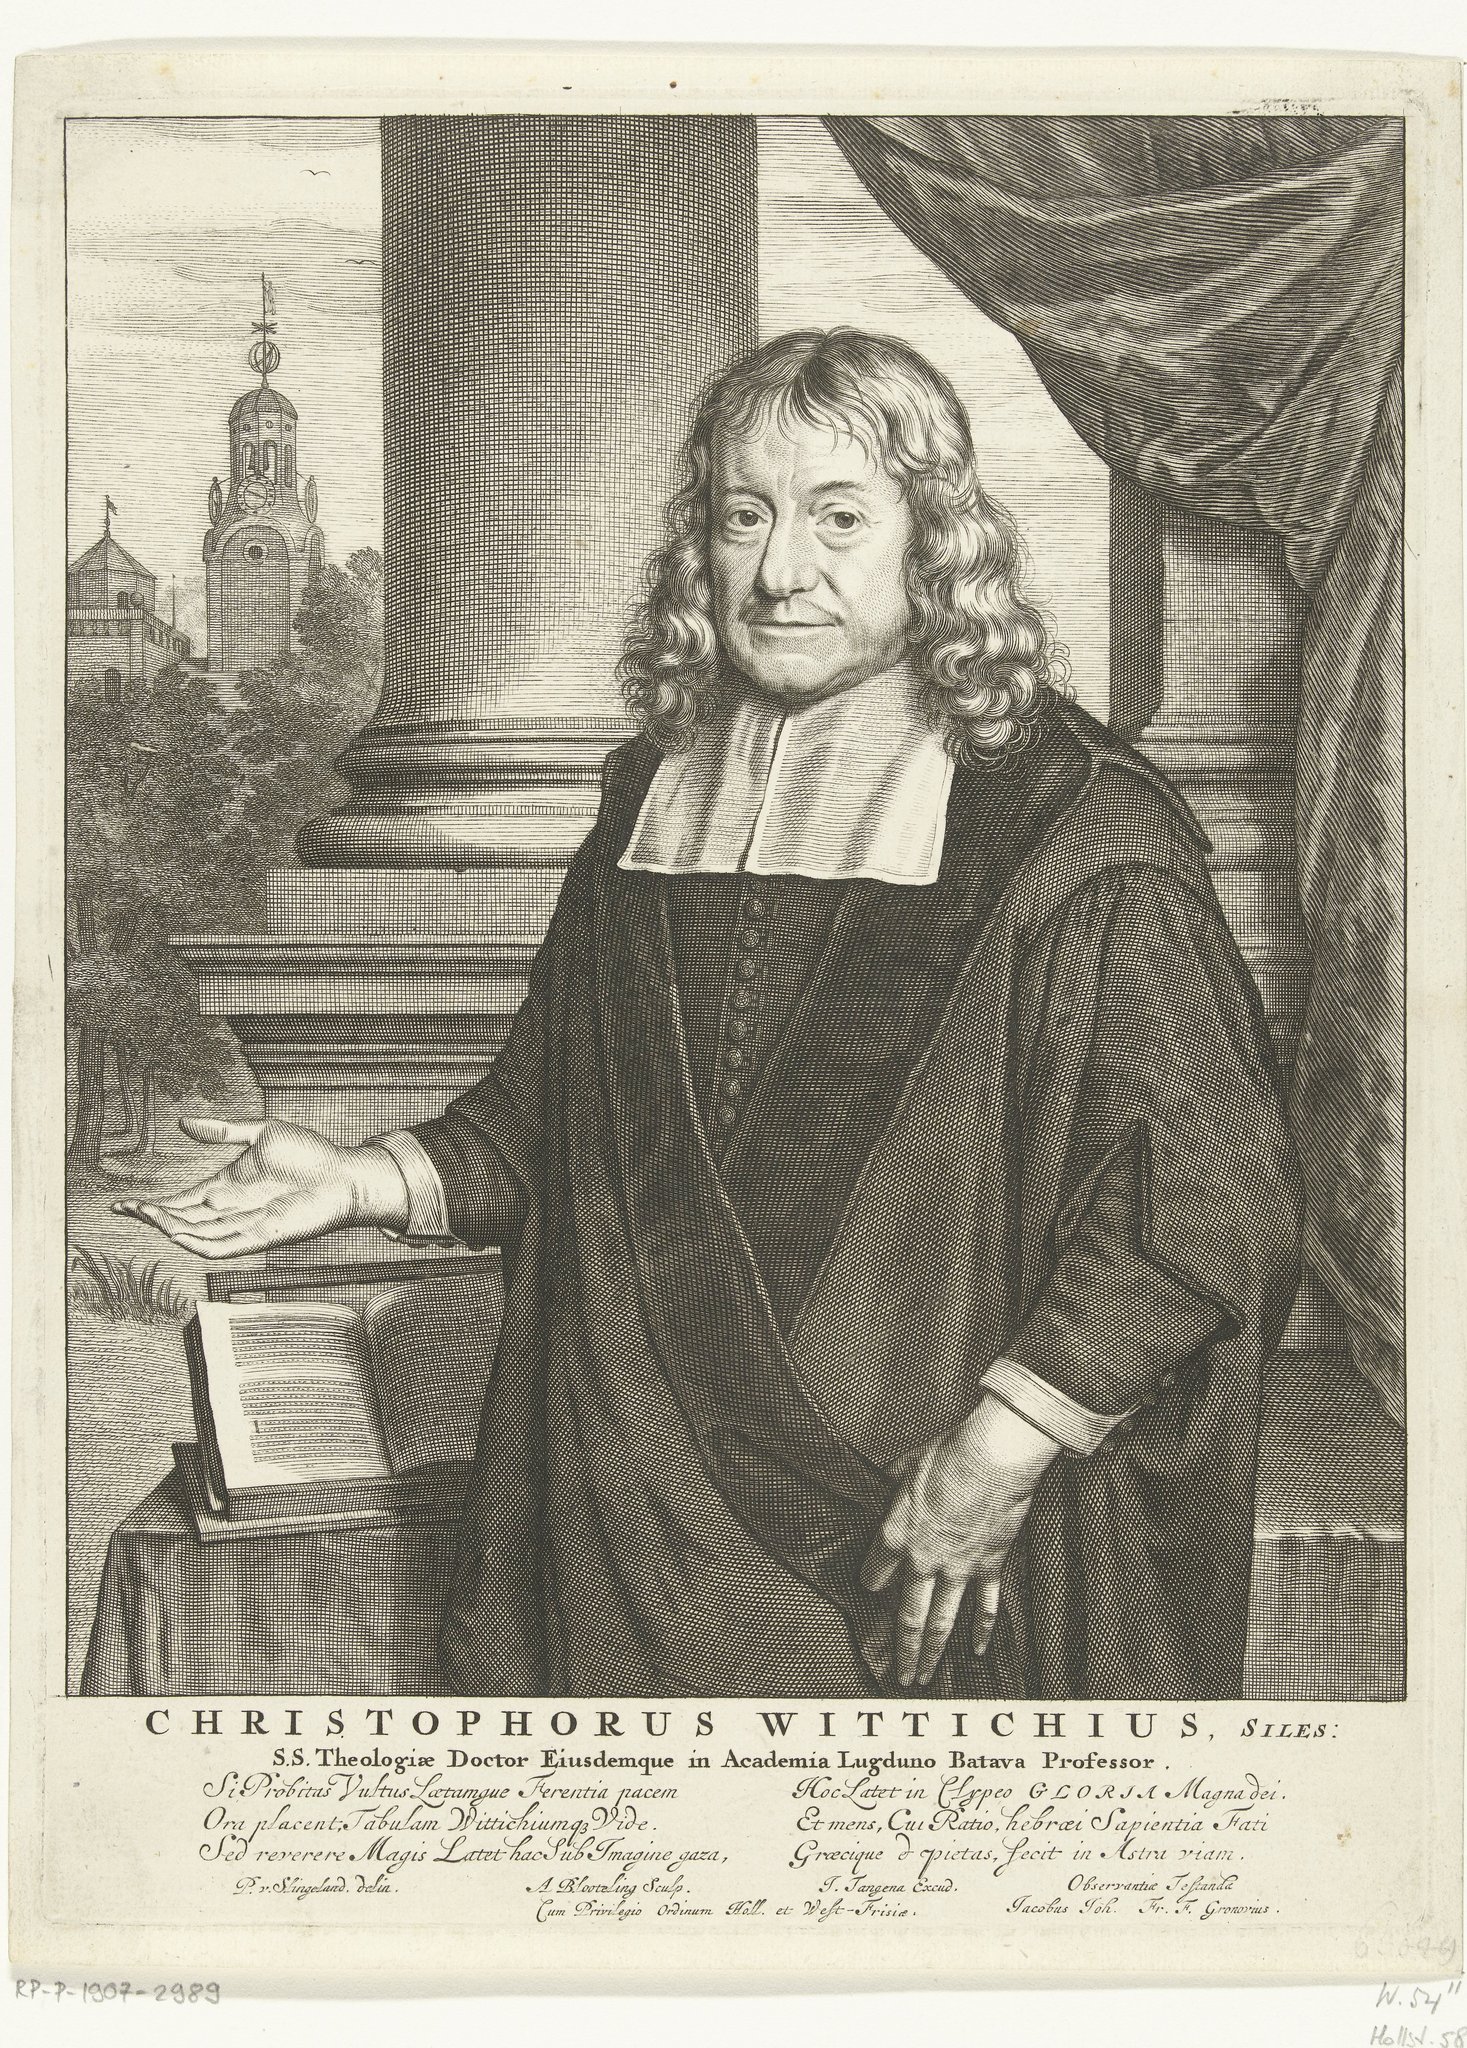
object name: print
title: Portret van Christoph Wittich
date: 1687-1691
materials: paper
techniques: engraving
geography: leiden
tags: leiden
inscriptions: collector's mark: Lugt 2166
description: Portret van de Leidse theoloog Christoph Wittich. Wittich maakt een spreekgebaar, hij staat voor een tafel met een bijbel. Op de achtergrond is de torenspits van een kerk te zien. In de ondermarge een Latijns vers over de geportretteerde.